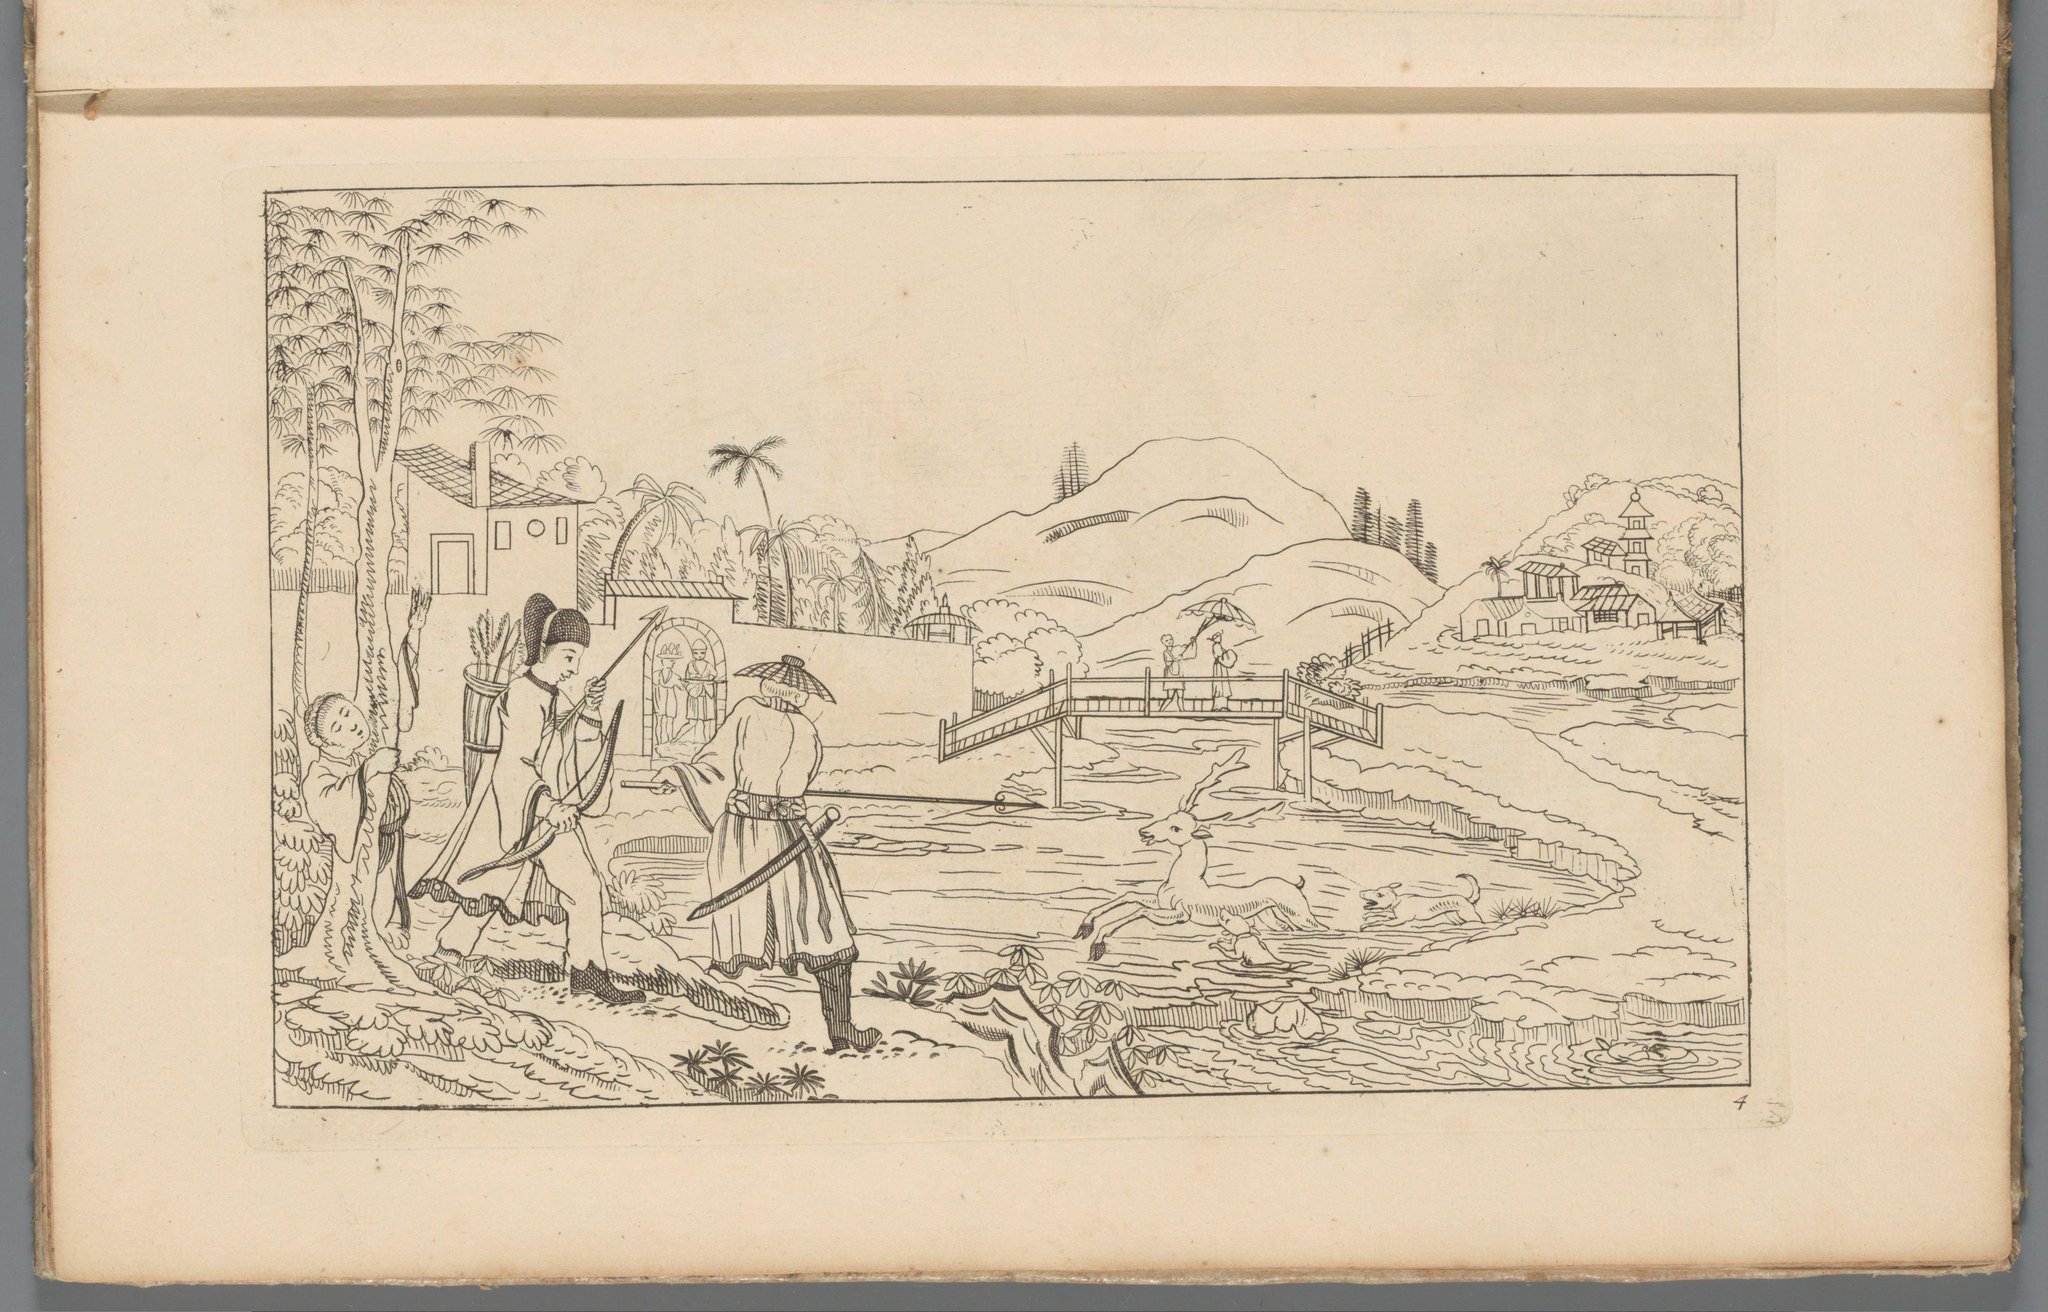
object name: ornament print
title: Chinese jachttaferelen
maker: pieter schenk (ii)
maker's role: draughtsman, print maker, publisher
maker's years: 1693-1775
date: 1727-1775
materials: paper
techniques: etching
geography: amsterdam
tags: chinese, landscapes in the temperate zone, hunt ~ hoofed animals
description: Rivierlandschap met een door jachthonden achterna gezeten hert. Links op de oever een man met een speer en een man met pijl en boog. Prent maakt deel uit van een album.